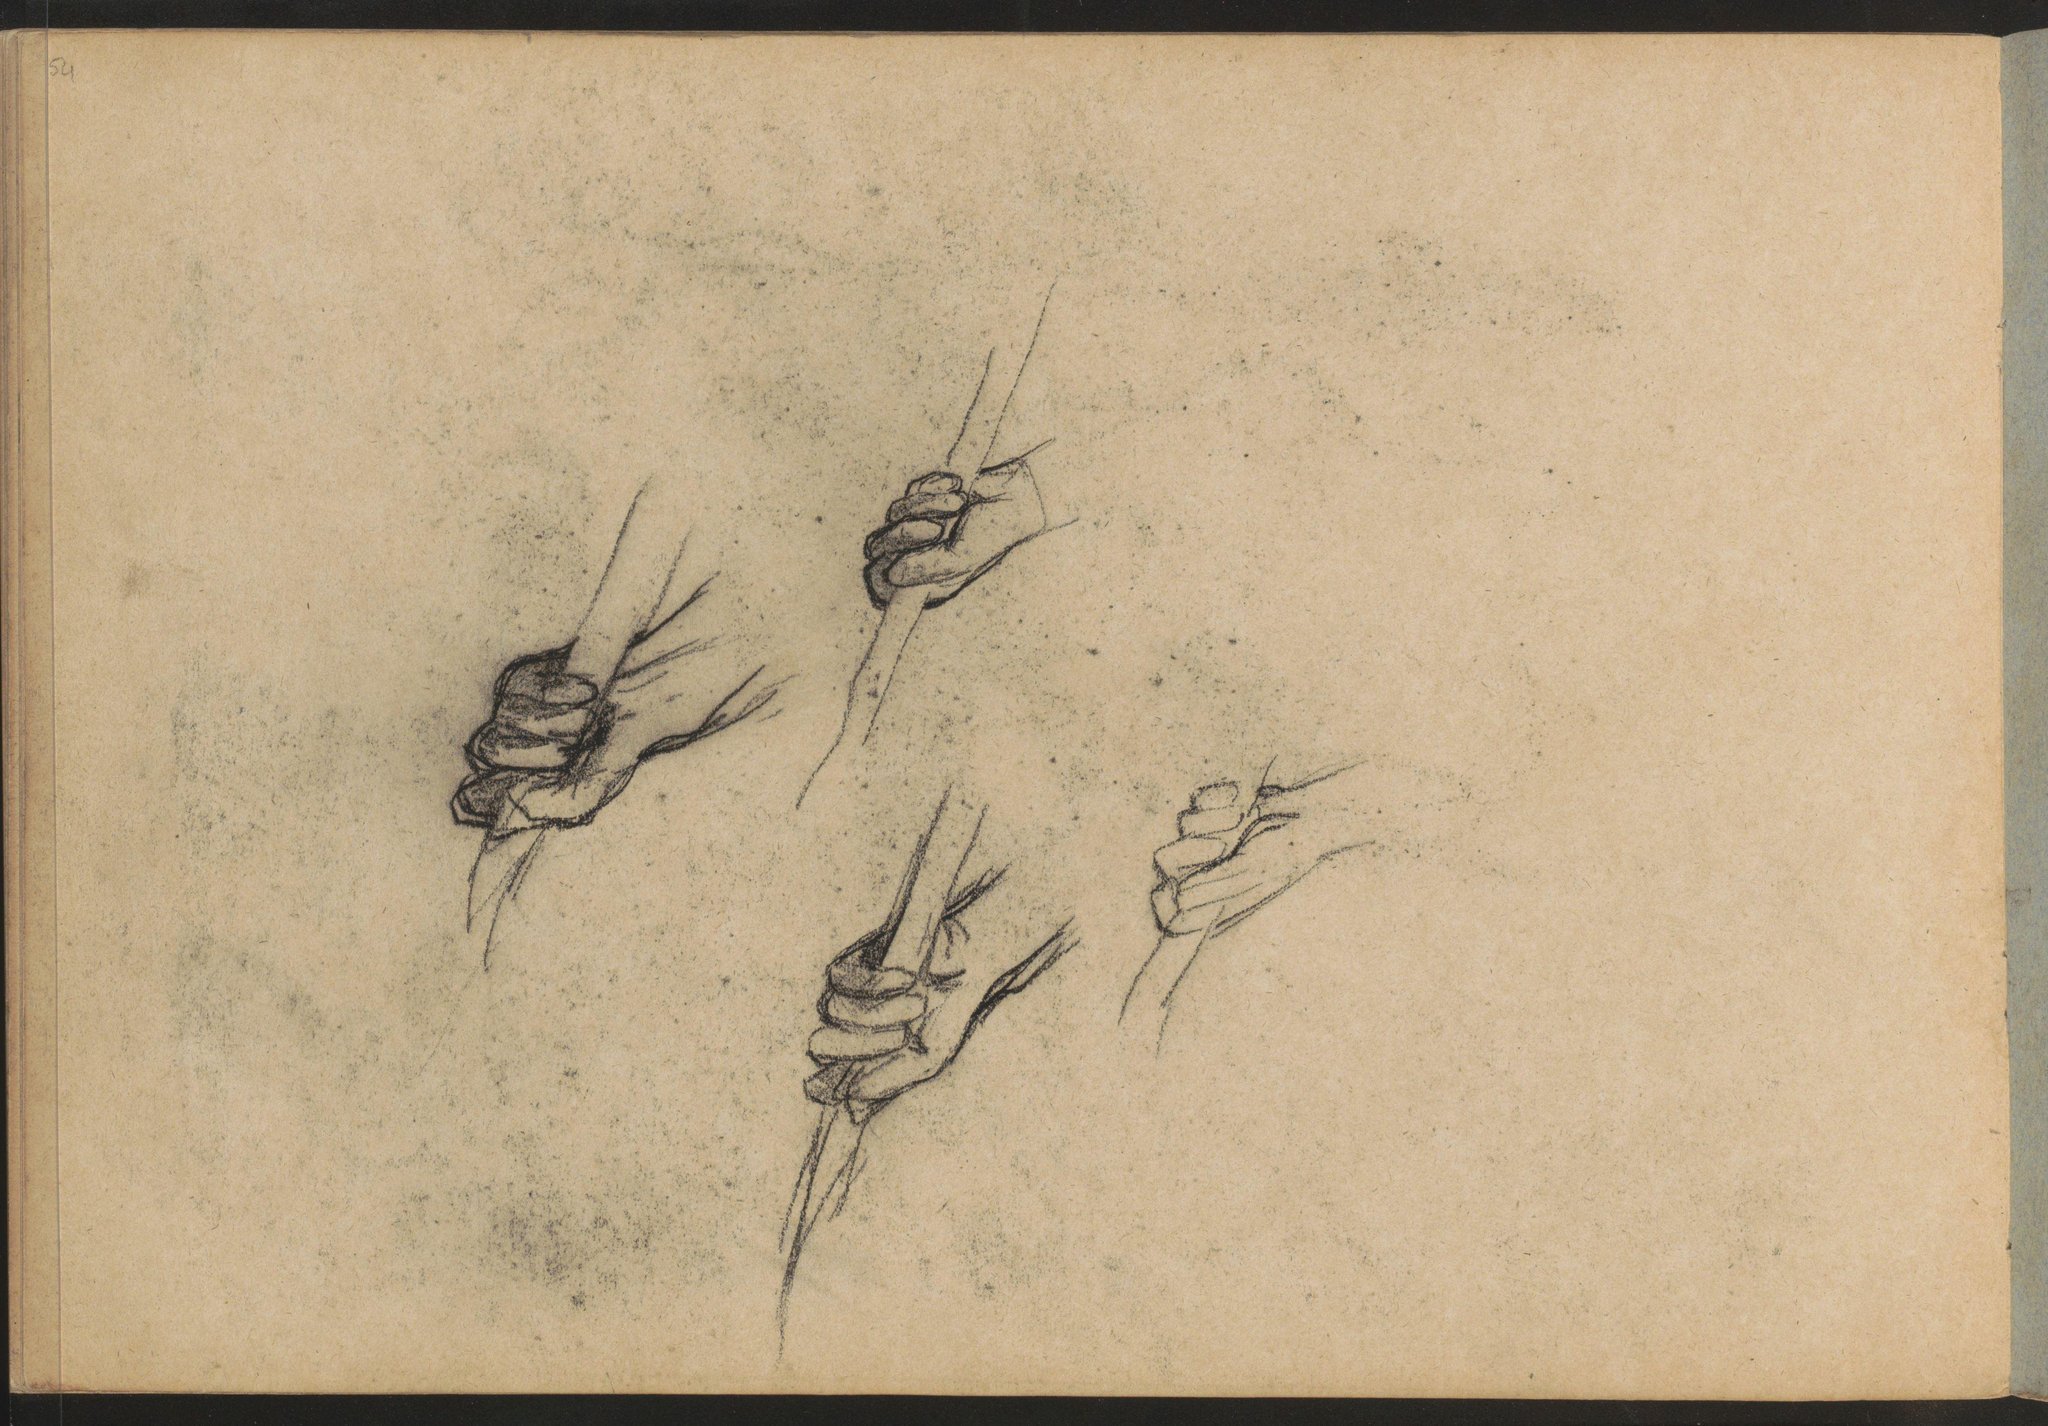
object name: sketchbook leaf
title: Studieblad met handen die een stok vasthouden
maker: willem witsen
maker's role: draughtsman, painter, print maker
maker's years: 1860-1923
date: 1884-1887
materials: chalk, paper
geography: ewijkshoeve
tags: carrying something, hand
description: Pagina 54 uit een schetsboek met 29 bladen.